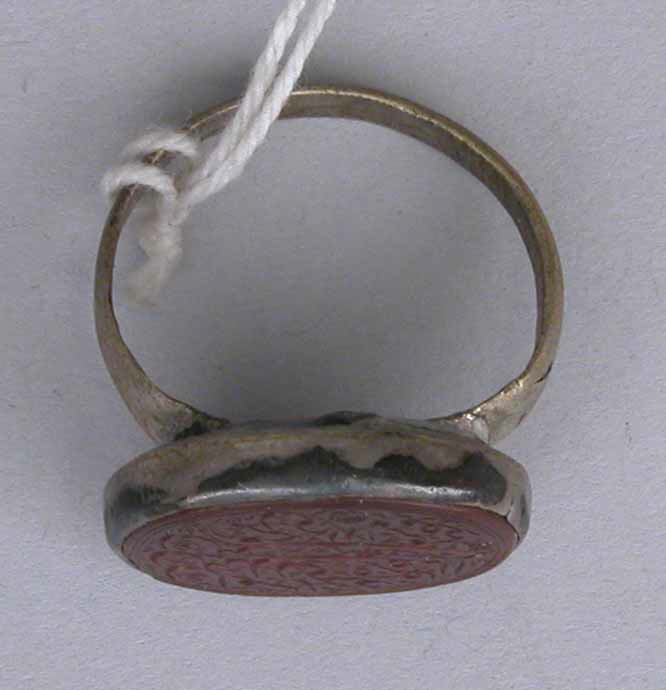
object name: ring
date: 1767-1800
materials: gemstone, silver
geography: india